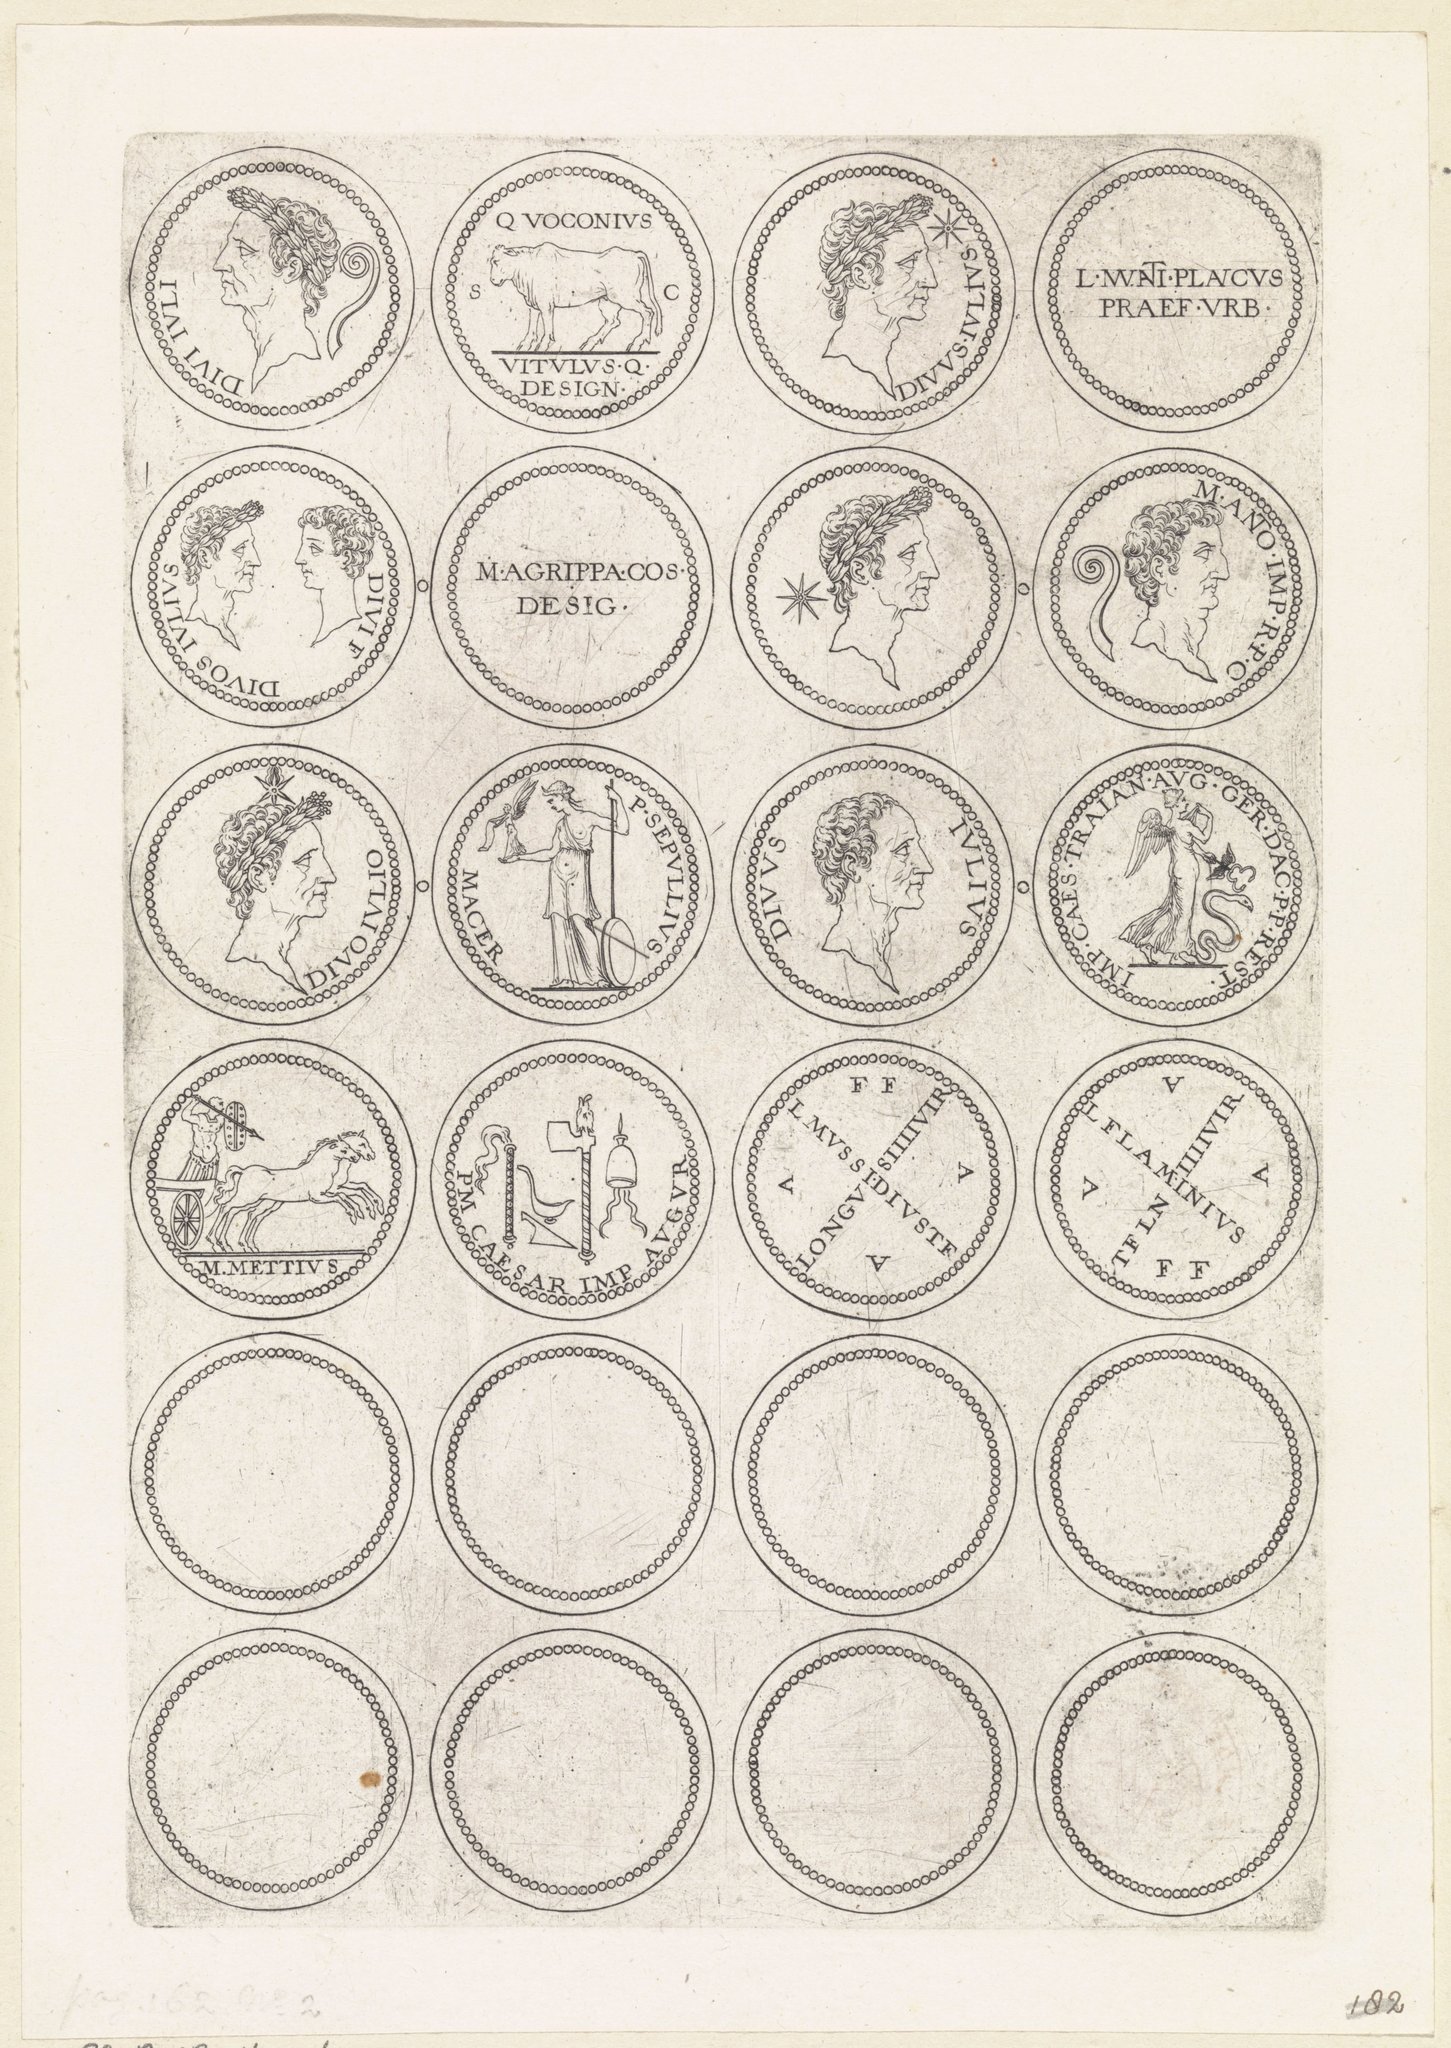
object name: print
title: Romeinse munten van keizers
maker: theodoor van thulden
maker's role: draughtsman, painter, print maker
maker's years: 1606-1669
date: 1642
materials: paper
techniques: engraving, etching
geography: antwerp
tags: coin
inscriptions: collector's mark: Lugt 240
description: Zestien Romeinse munten en acht lege velden voor munten onderaan.